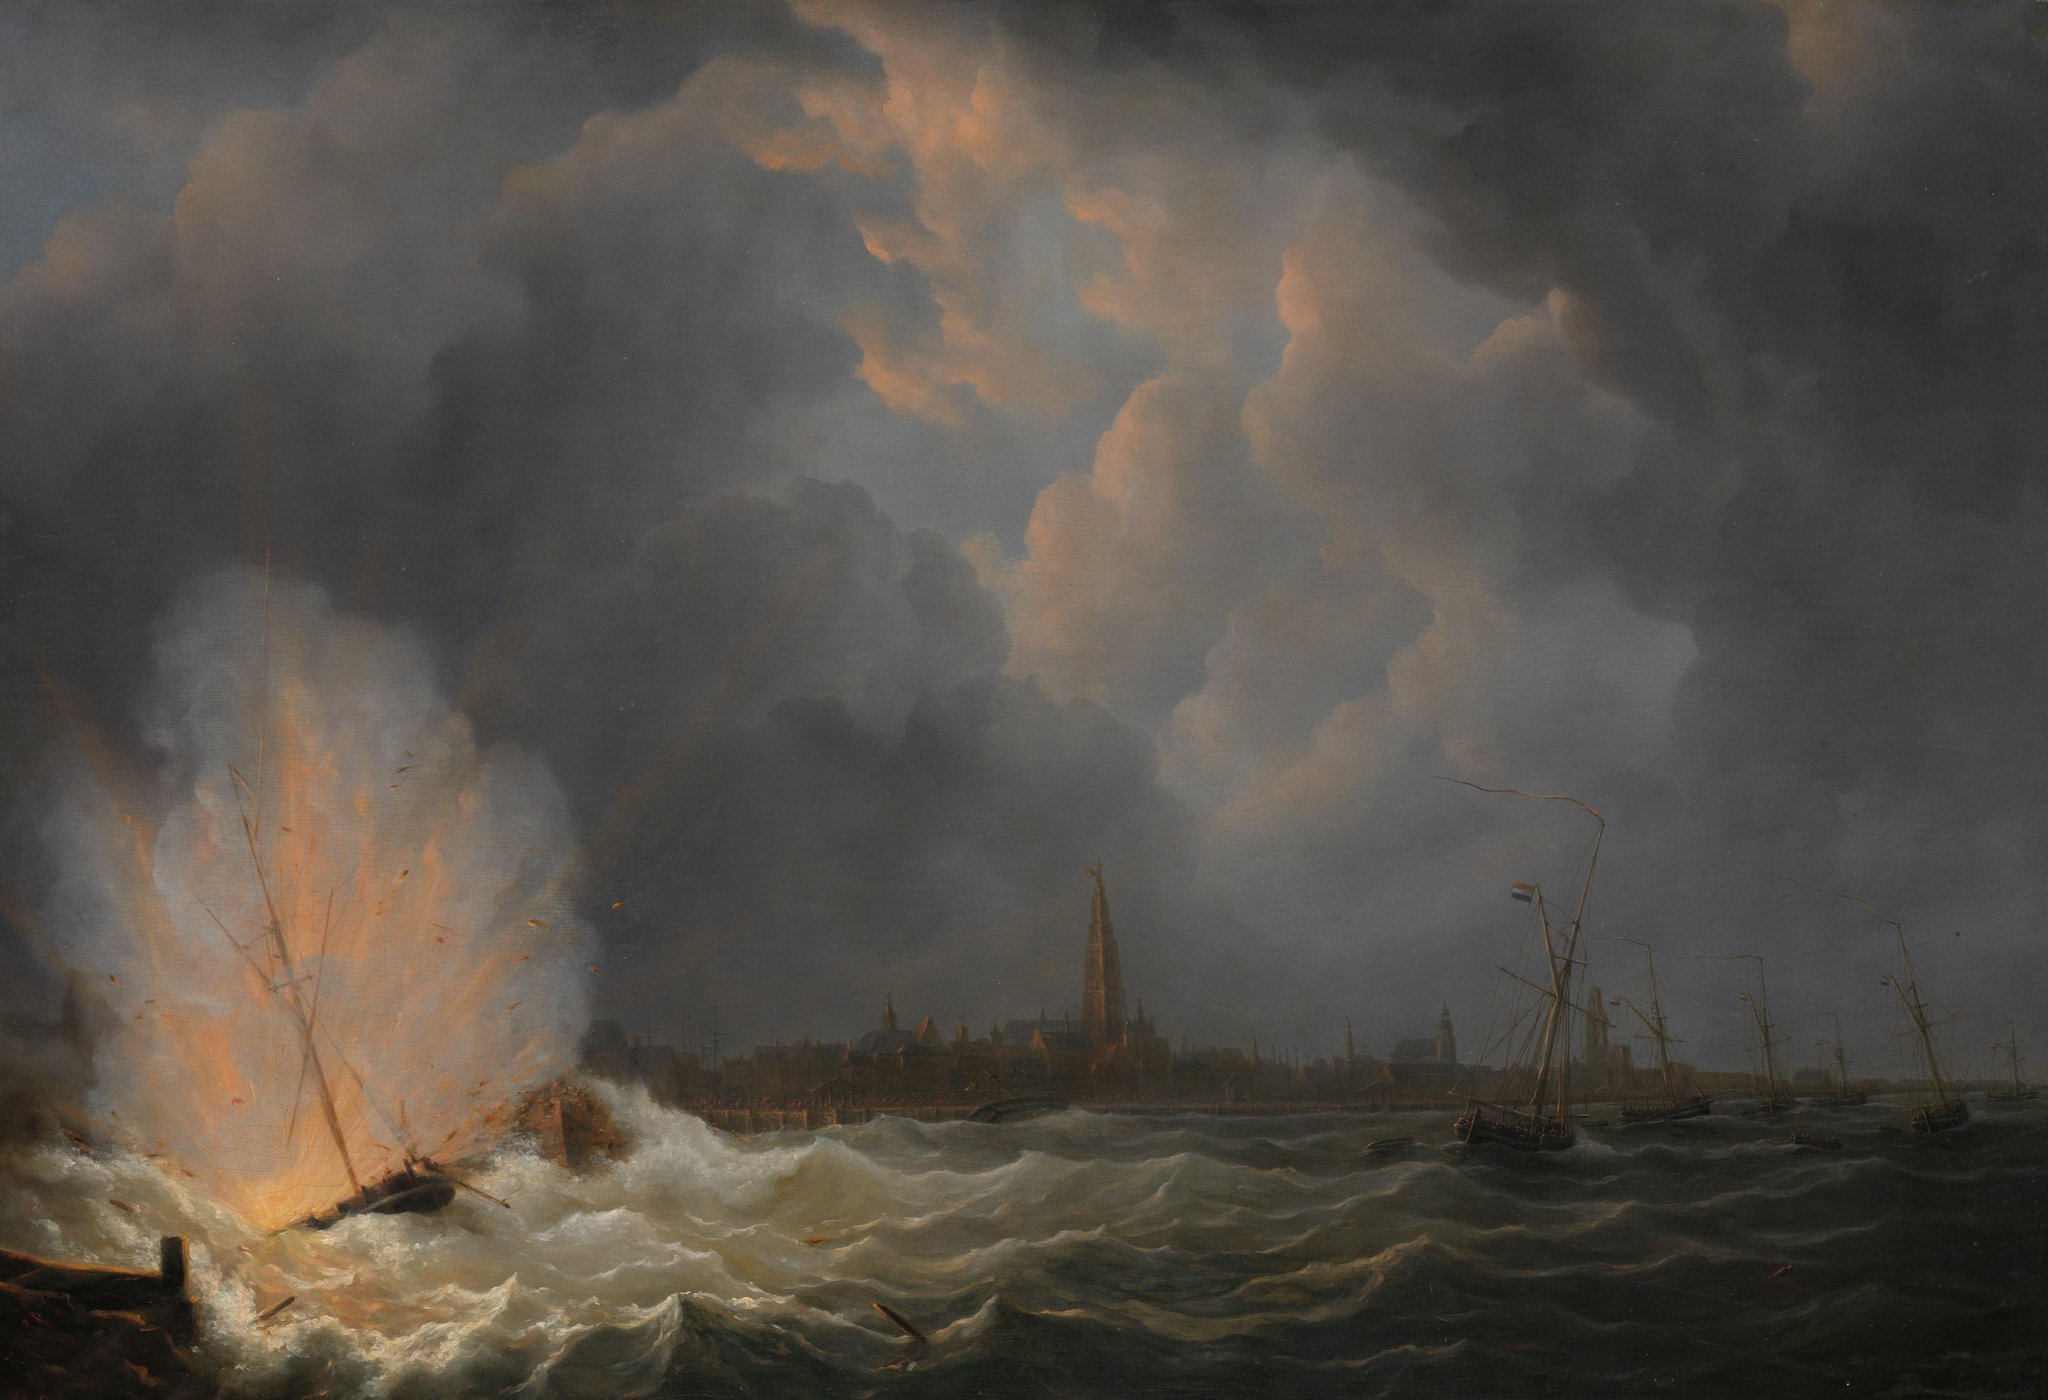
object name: painting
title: The Explosion of Gunboat nr 2, under Command of Jan van Speyk, off Antwerp, 5 February 1831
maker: martinus schouman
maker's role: draughtsman, painter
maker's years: 1770-1848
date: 1832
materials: oil, panel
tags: amsterdam, jan van speyk, seeking death, suicide, prospect of city, town panorama, silhouette of city, gunpowder disaster, antwerp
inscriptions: signature and date: ‘M. Schouman 1832’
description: The explosion of Dutch Gunboat No. 2 under command of Jan van Speyk on the Scheldt at Antwerp, 5 February 1831, by M. Schouman, 1832. To avoid falling in Belgian hands Van Speyk blew up his own ship. In Holland this created a sensation. There was a massive demand for pictures. Many different artists portrayed the event. Rather than show the dramatic moment when Van Speyk set the powder alight, Schouman portrayed the fatal result.